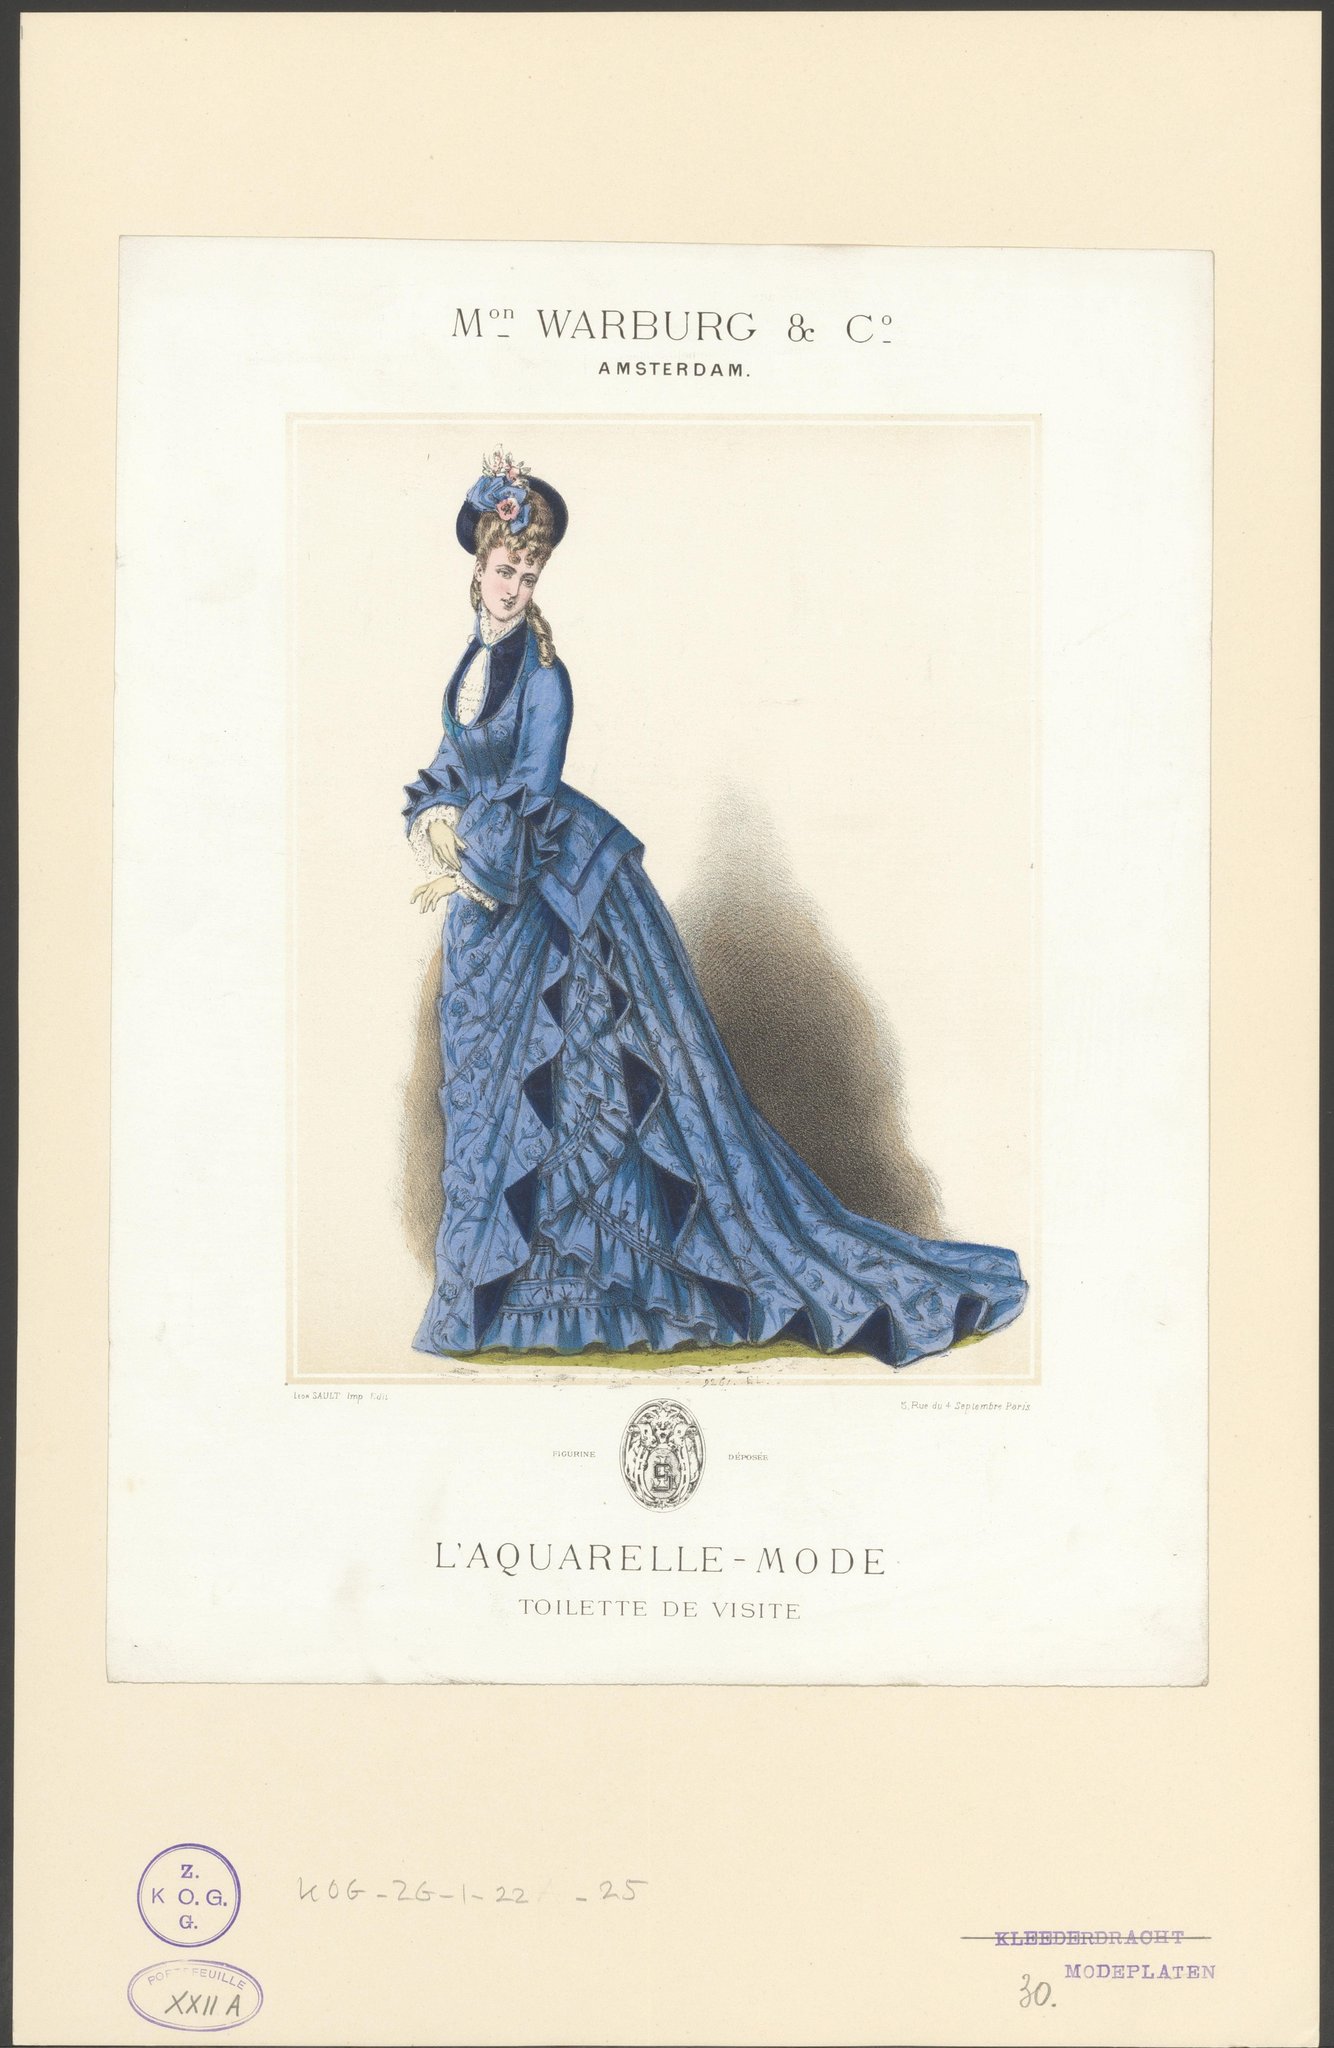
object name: print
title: Toilette de Visite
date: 1875-1886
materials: paper, watercolor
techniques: hand coloring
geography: paris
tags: fashion plates, clothes, costume (+ women's clothes), dress, gown (+ women's clothes)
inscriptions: collector's mark: Lugt 1641, collector's mark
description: Vrouw in blauwe japon, staande naar links. Met vermelding van 'Mon. Warburg & Co. Amsterdam'. Prent uit het modetijdschrift L'Aquarelle-Mode (1866-1892). nr. 9261. Onderwerpsrubrieken binnen de Atlas Zeden en Gewoonten: De Kleeding, Modeplaten.